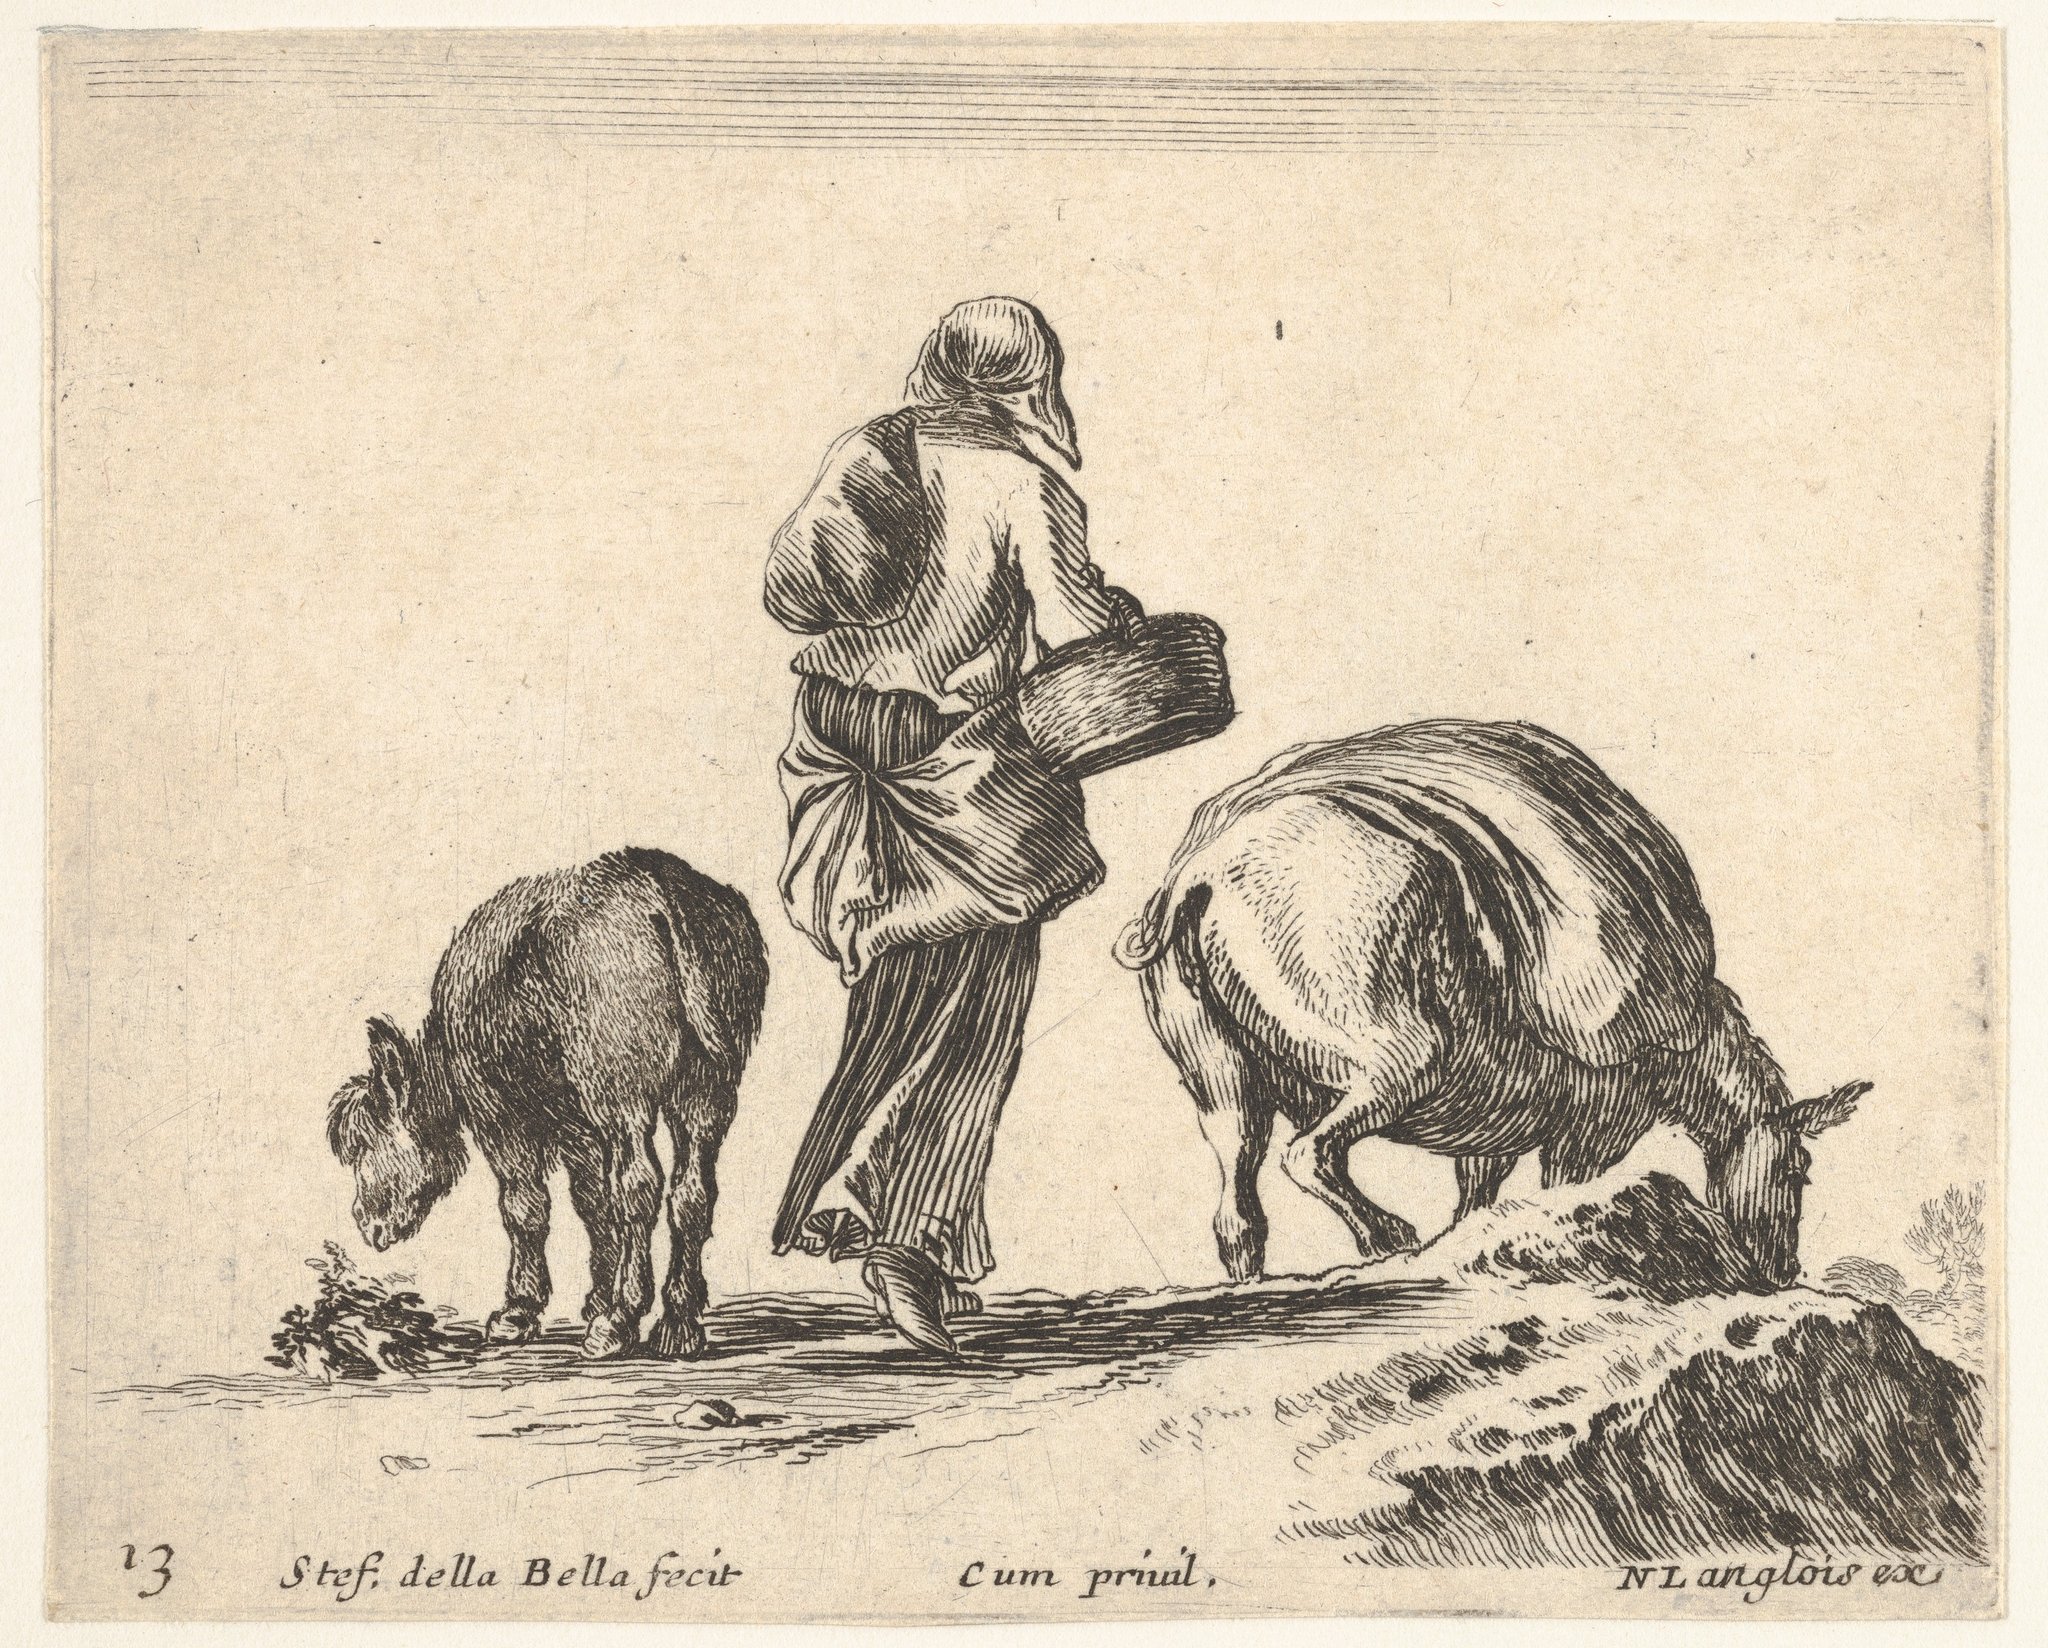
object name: print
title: Plate 13: a peasant woman, seen from the back, holding a basket in center, a donkey to left and a horse with a pack on its back to right, from "Diversi Capricci"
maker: stefano della bella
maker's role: artist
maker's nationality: italian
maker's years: 1610-1664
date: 1644-1647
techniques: etching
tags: women,donkeys,horses